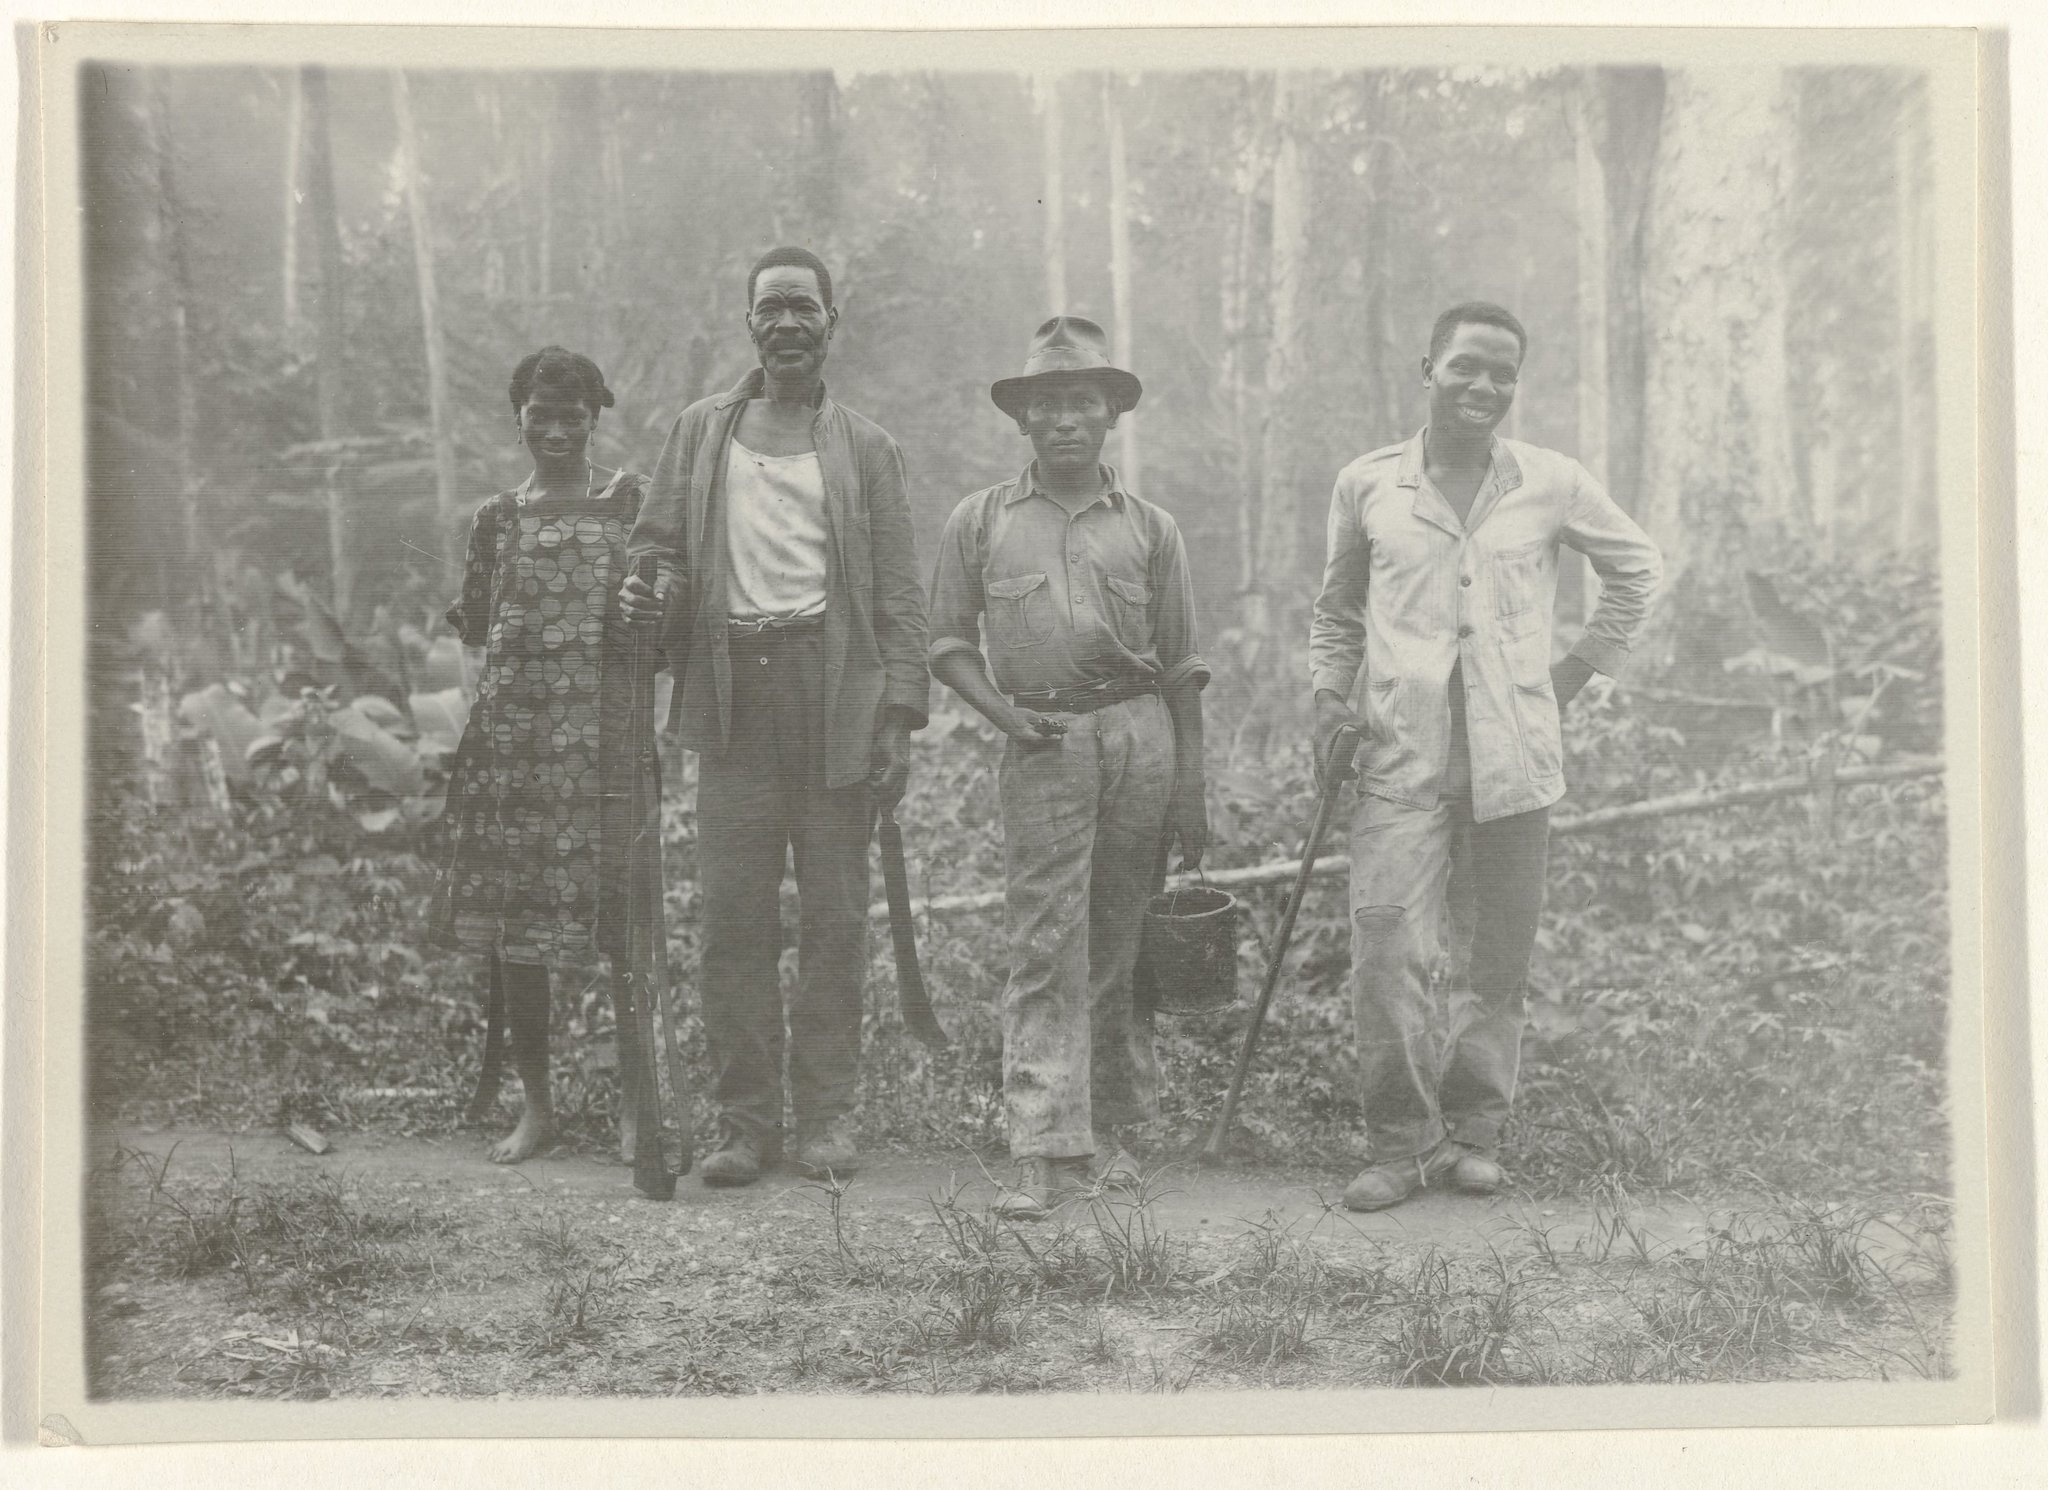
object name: photograph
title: Arbeiders in Moengo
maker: Anonymous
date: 1929-1930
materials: photographic support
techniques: photography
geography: suriname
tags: albina, moengo